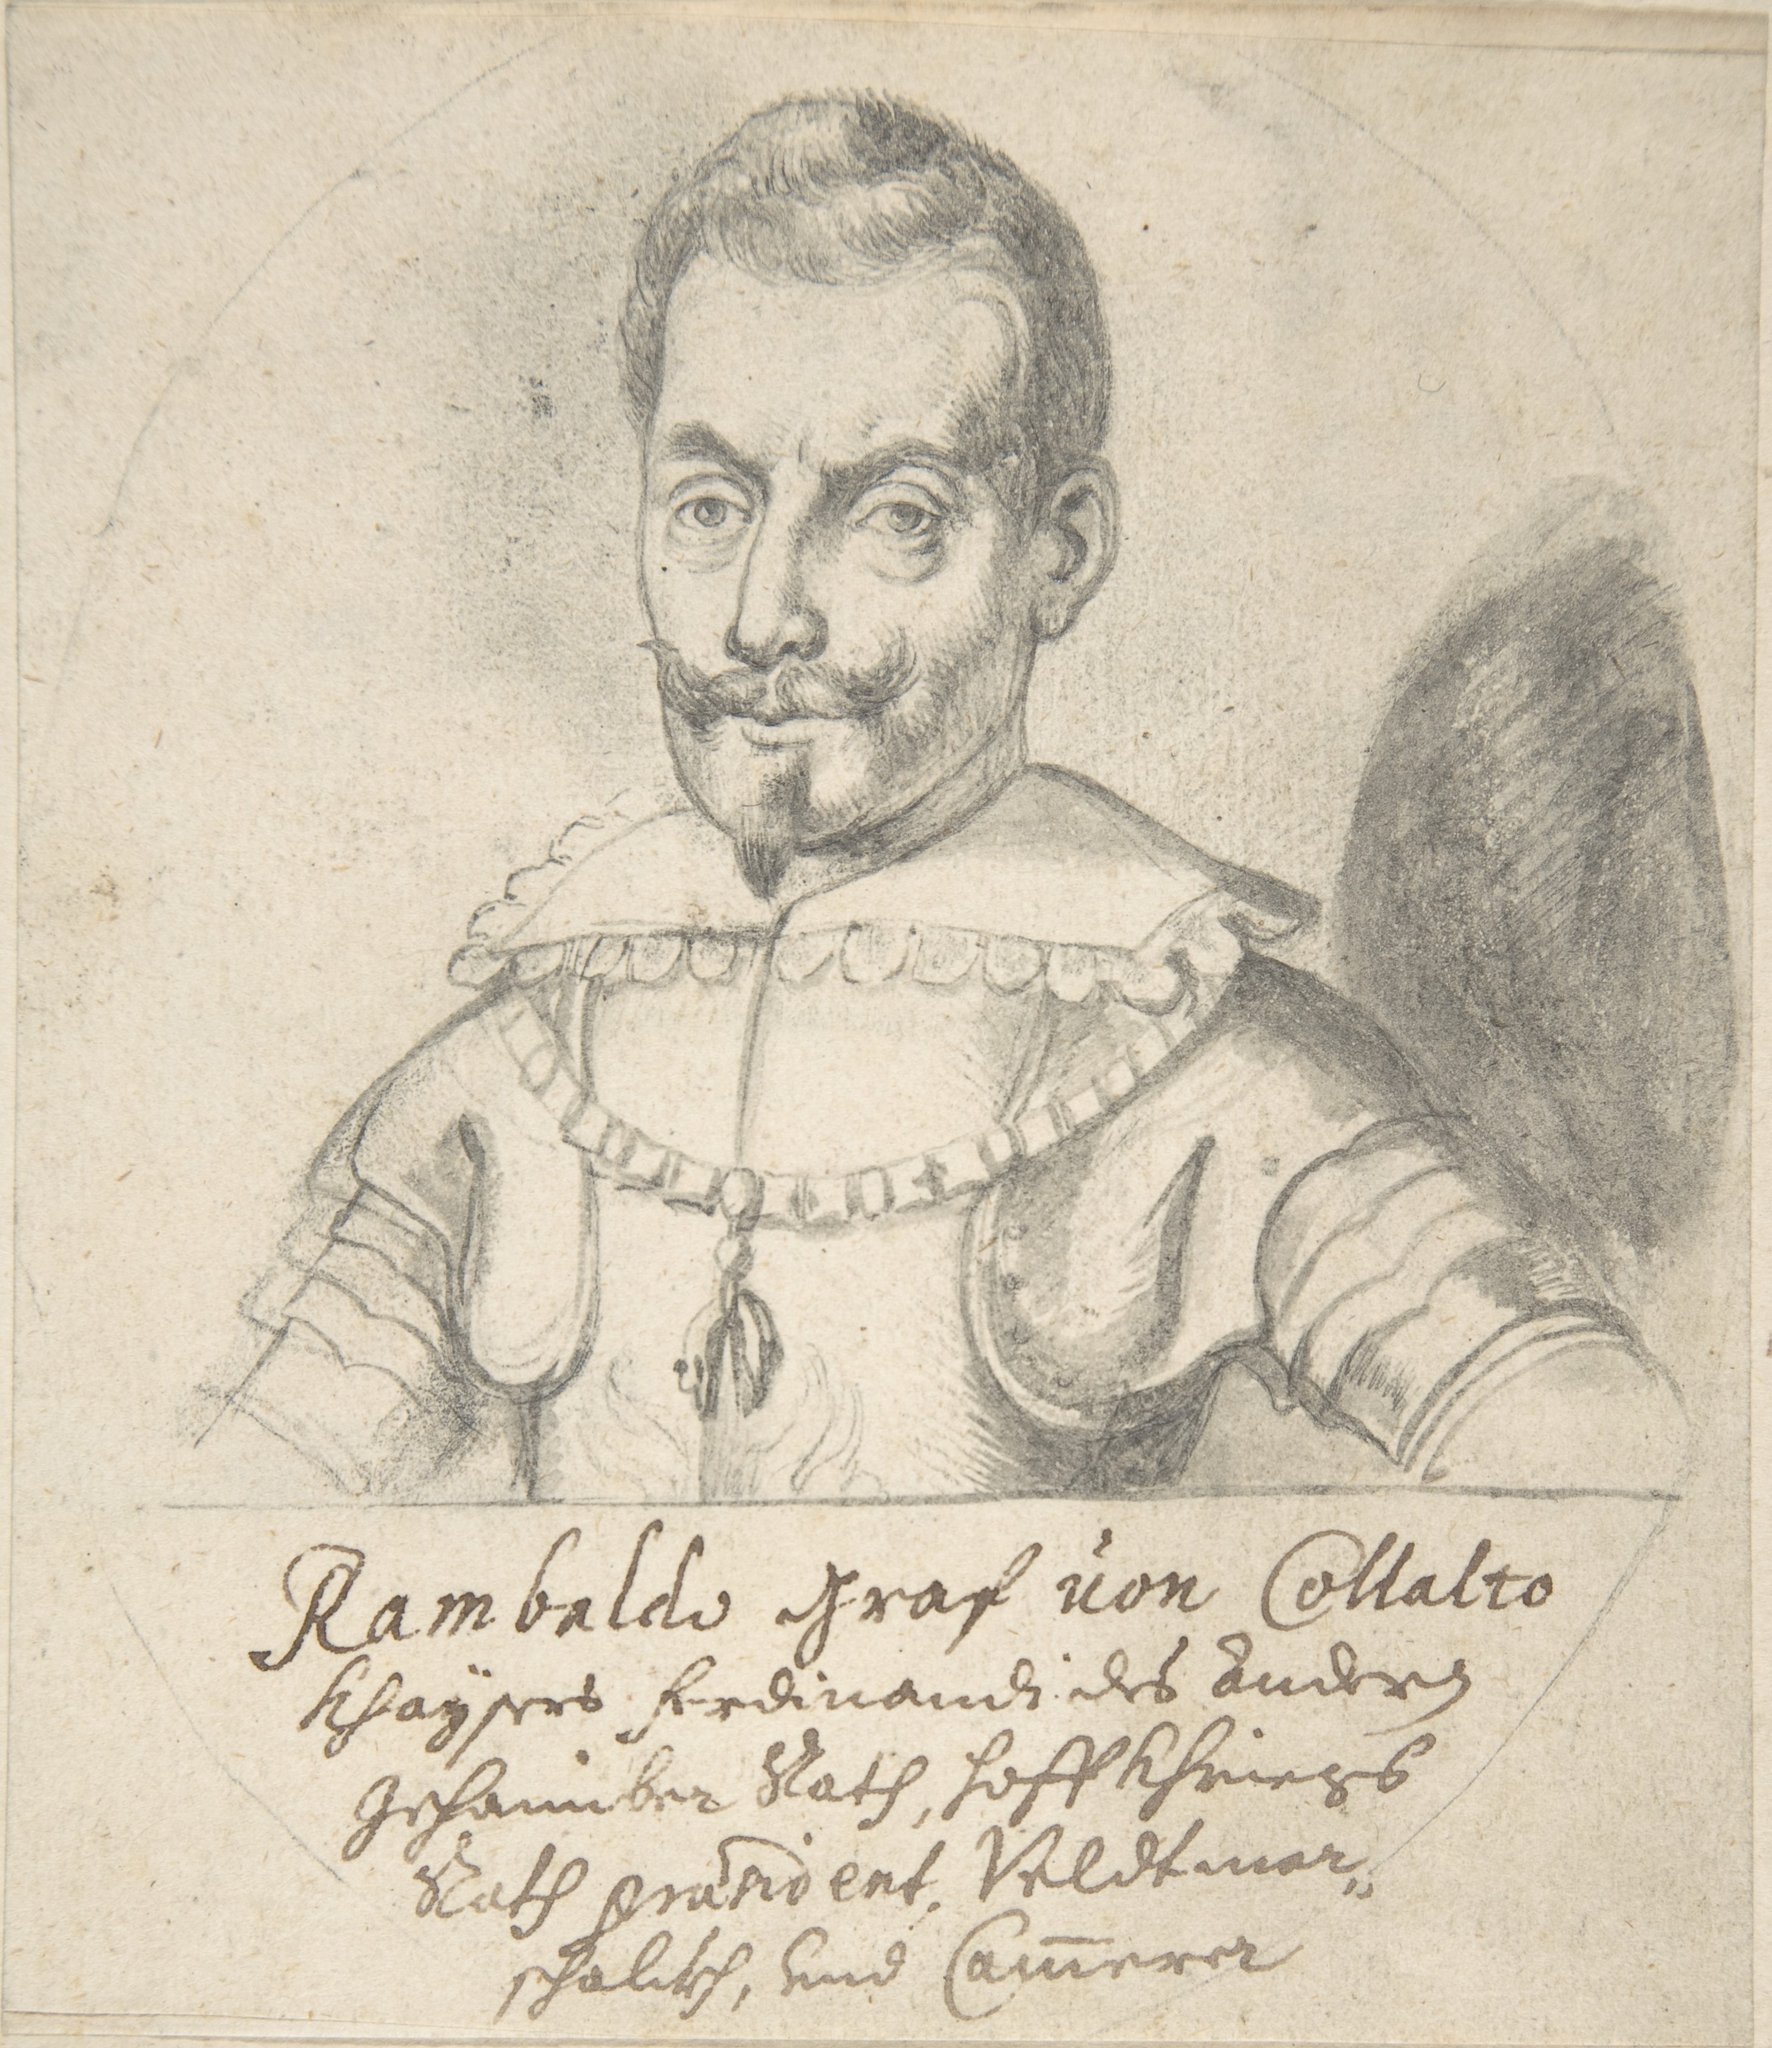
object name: drawing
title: Portrait of Rambaldo, graf von Collalto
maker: anonymous, flemish, 17th century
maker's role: artist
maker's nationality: flemish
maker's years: 1600-1700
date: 1601-1700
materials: board, chalk, down, ink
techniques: brush, incising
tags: men,portraits